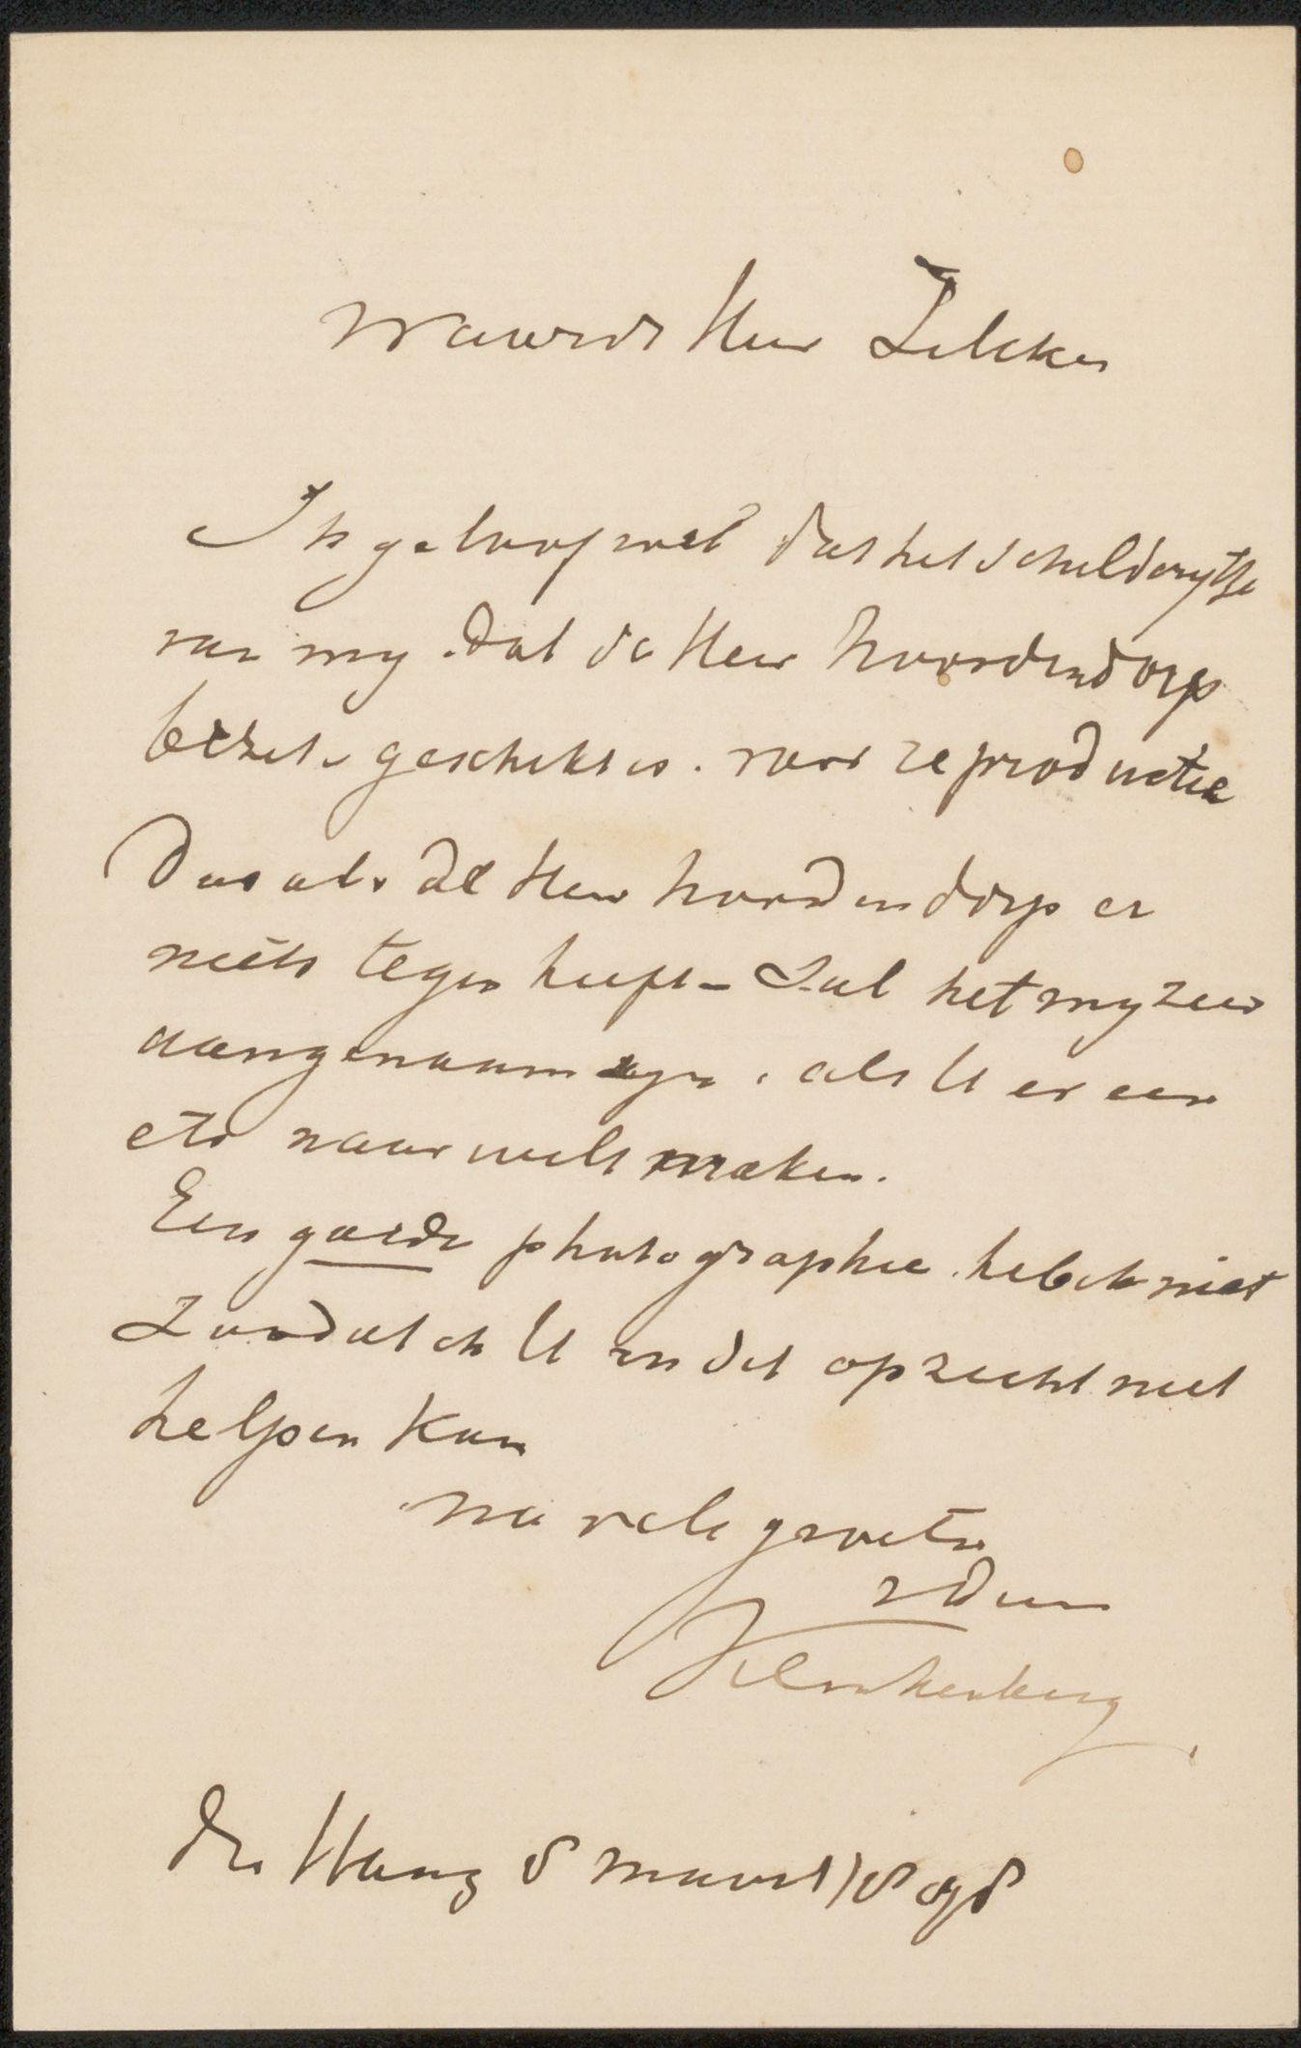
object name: letter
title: Brief aan Philip Zilcken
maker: johannes christiaan karel klinkenberg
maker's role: draughtsman, painter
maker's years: 1852-1924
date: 1898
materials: ink, paper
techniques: pen, writing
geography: the hague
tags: philip zilcken, photography, cinematography, painting (including book-illumination, miniature-painting)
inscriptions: collector's mark: ‘RPK’